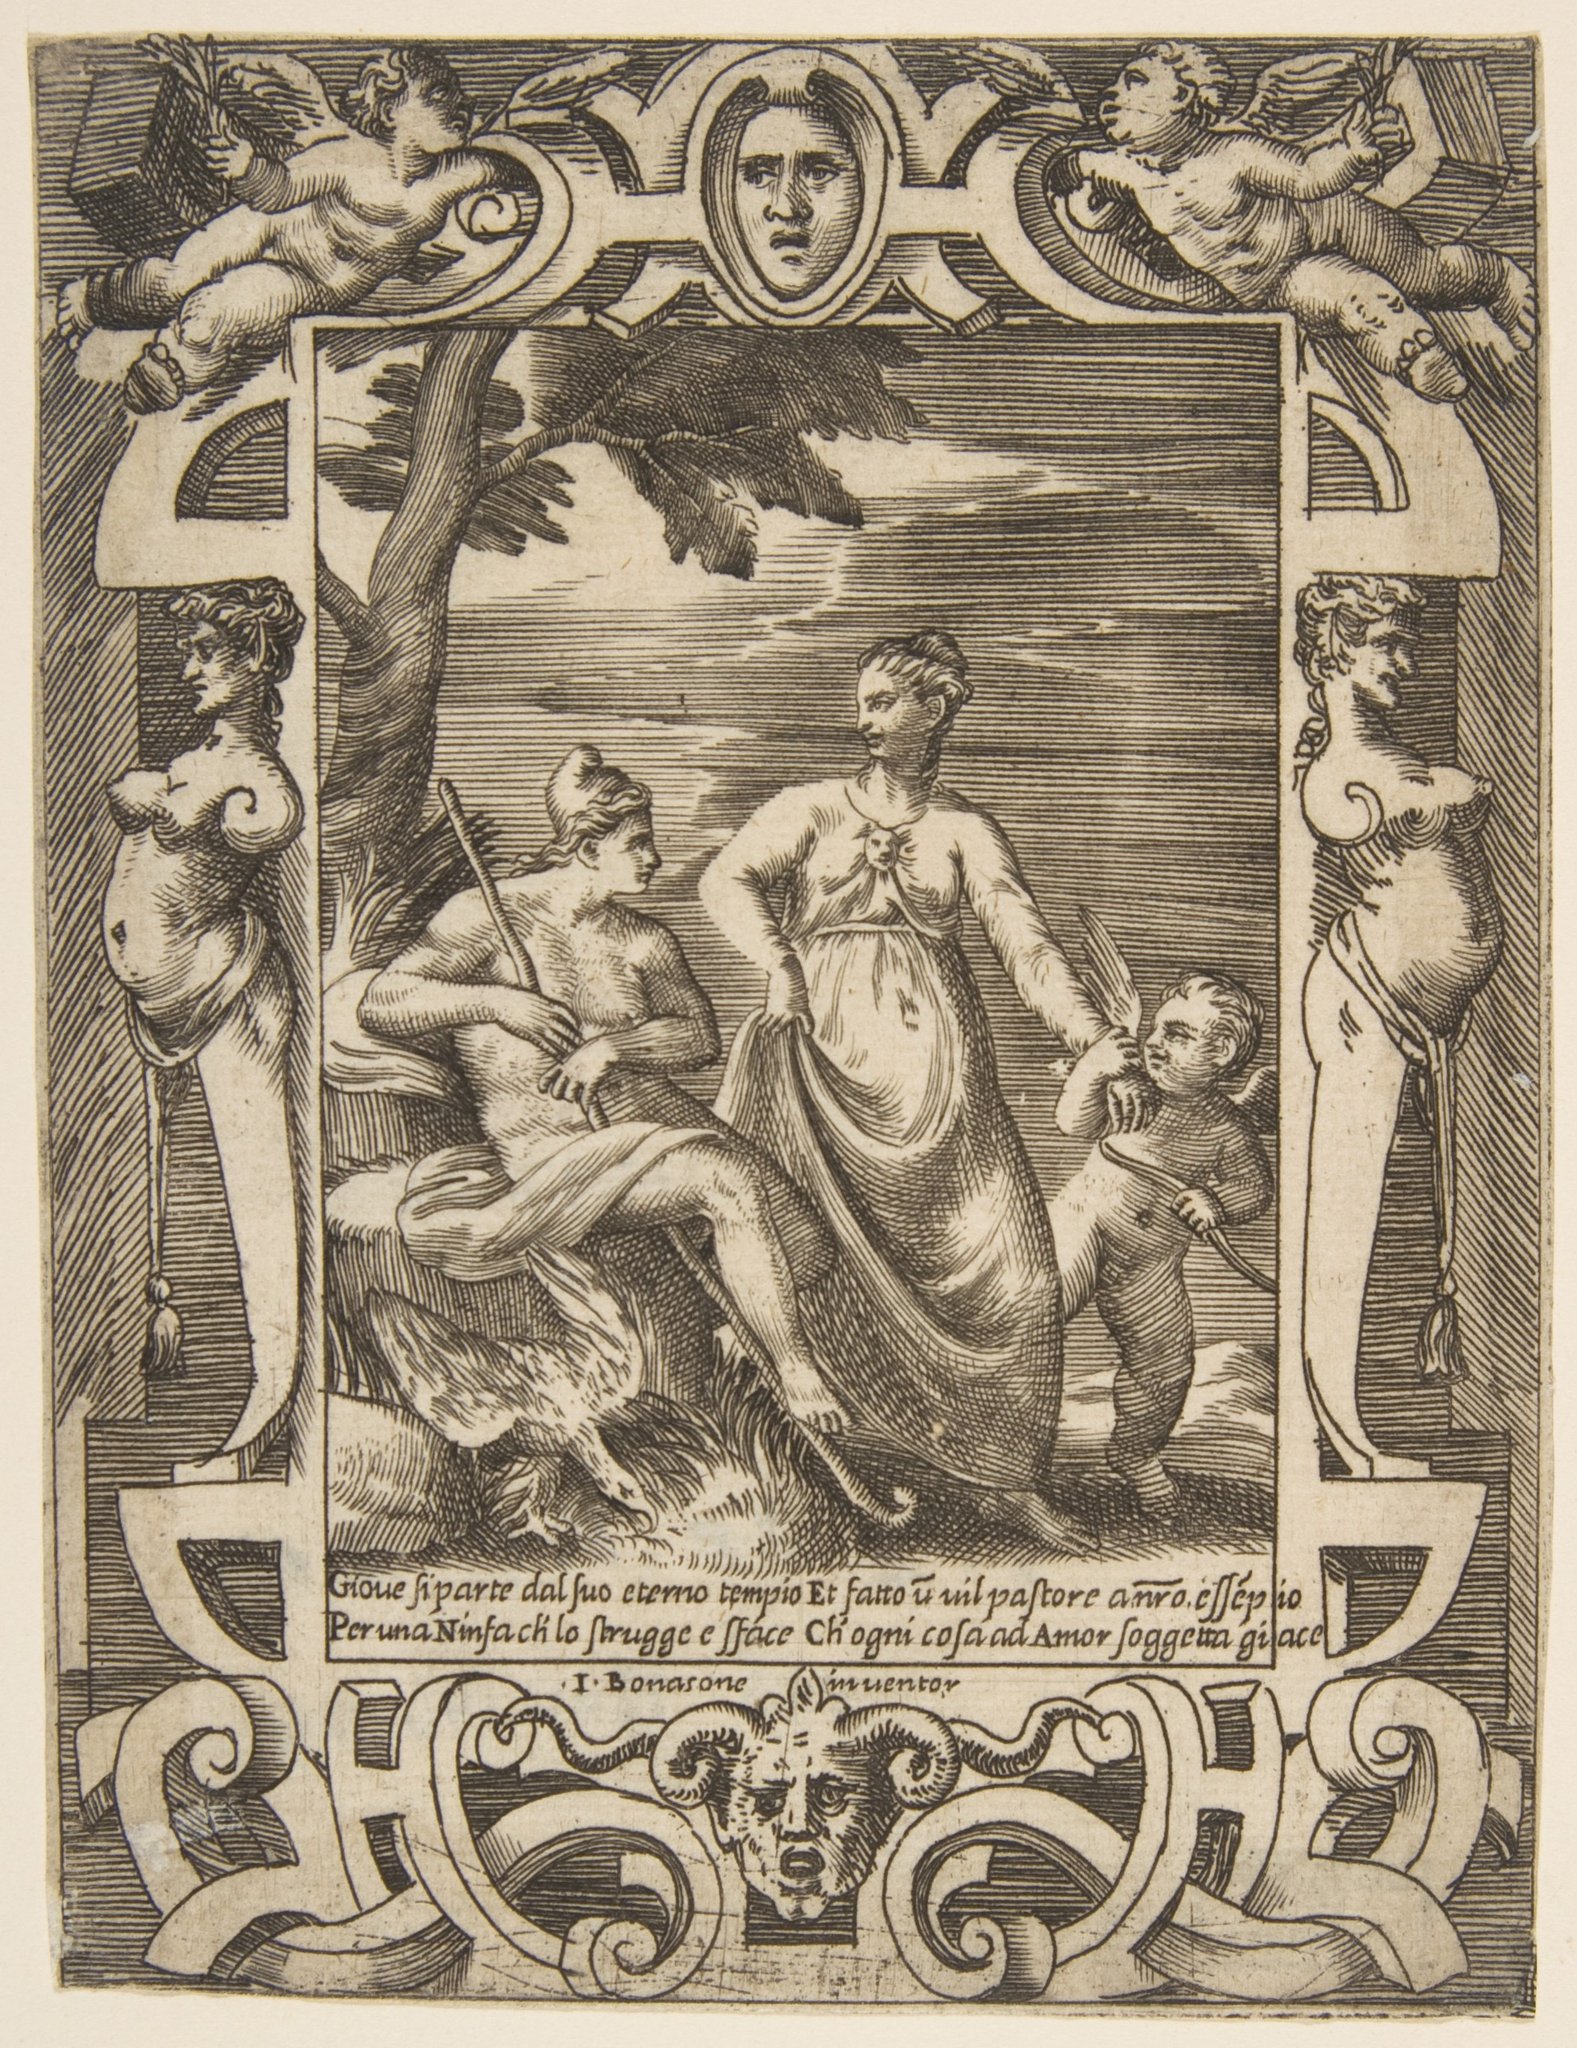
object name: print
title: Jupiter at left in the form of a shepherd accompanied by Mnemosyne, set within an elaborate cartouche, from "Loves, Rages and Jealousies of Juno"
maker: giulio bonasone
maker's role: artist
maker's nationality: italian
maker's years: 1510-1576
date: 1531-1576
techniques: engraving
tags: women,mythical creatures,putti,jupiter